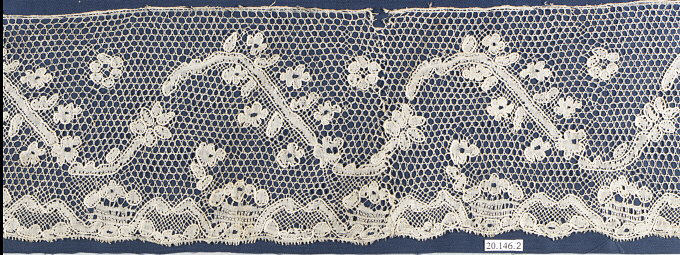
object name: fragment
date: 1801-1900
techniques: lace